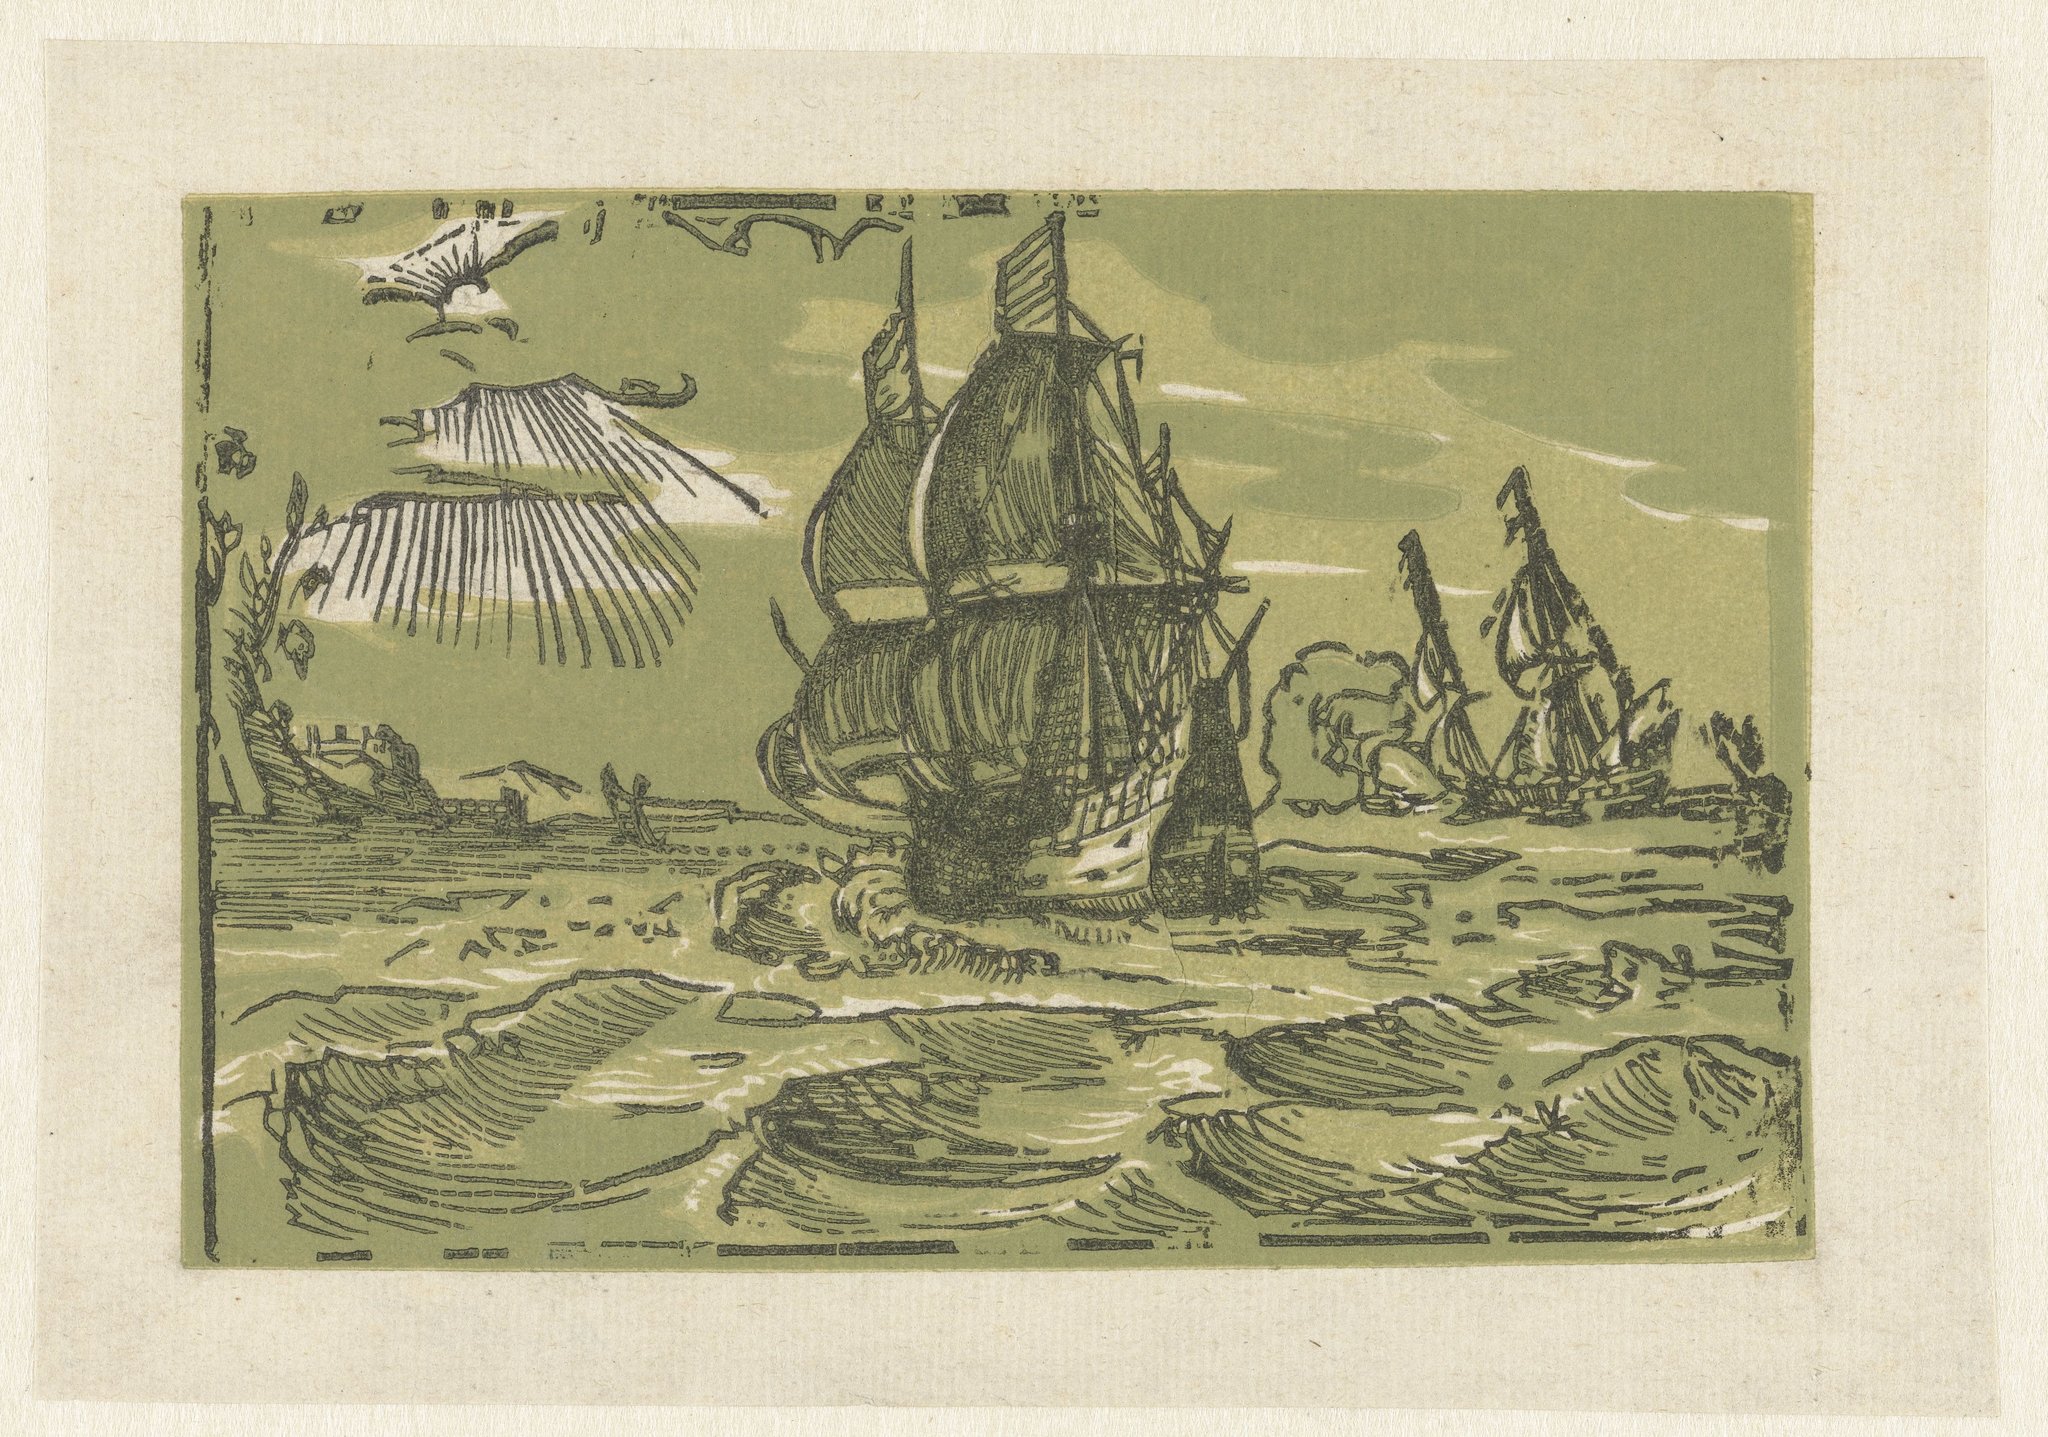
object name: print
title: Schepen voor een kust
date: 1585-1588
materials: paper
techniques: woodcut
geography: haarlem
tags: sea (seascape)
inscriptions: collector's mark: Lugt 2228a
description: Een groot schip voor een kust. Op de achtergrond nog een zeilschip, met rookwolken (of een golf) bij de achtersteven. De zon breekt linksboven door de wolken.